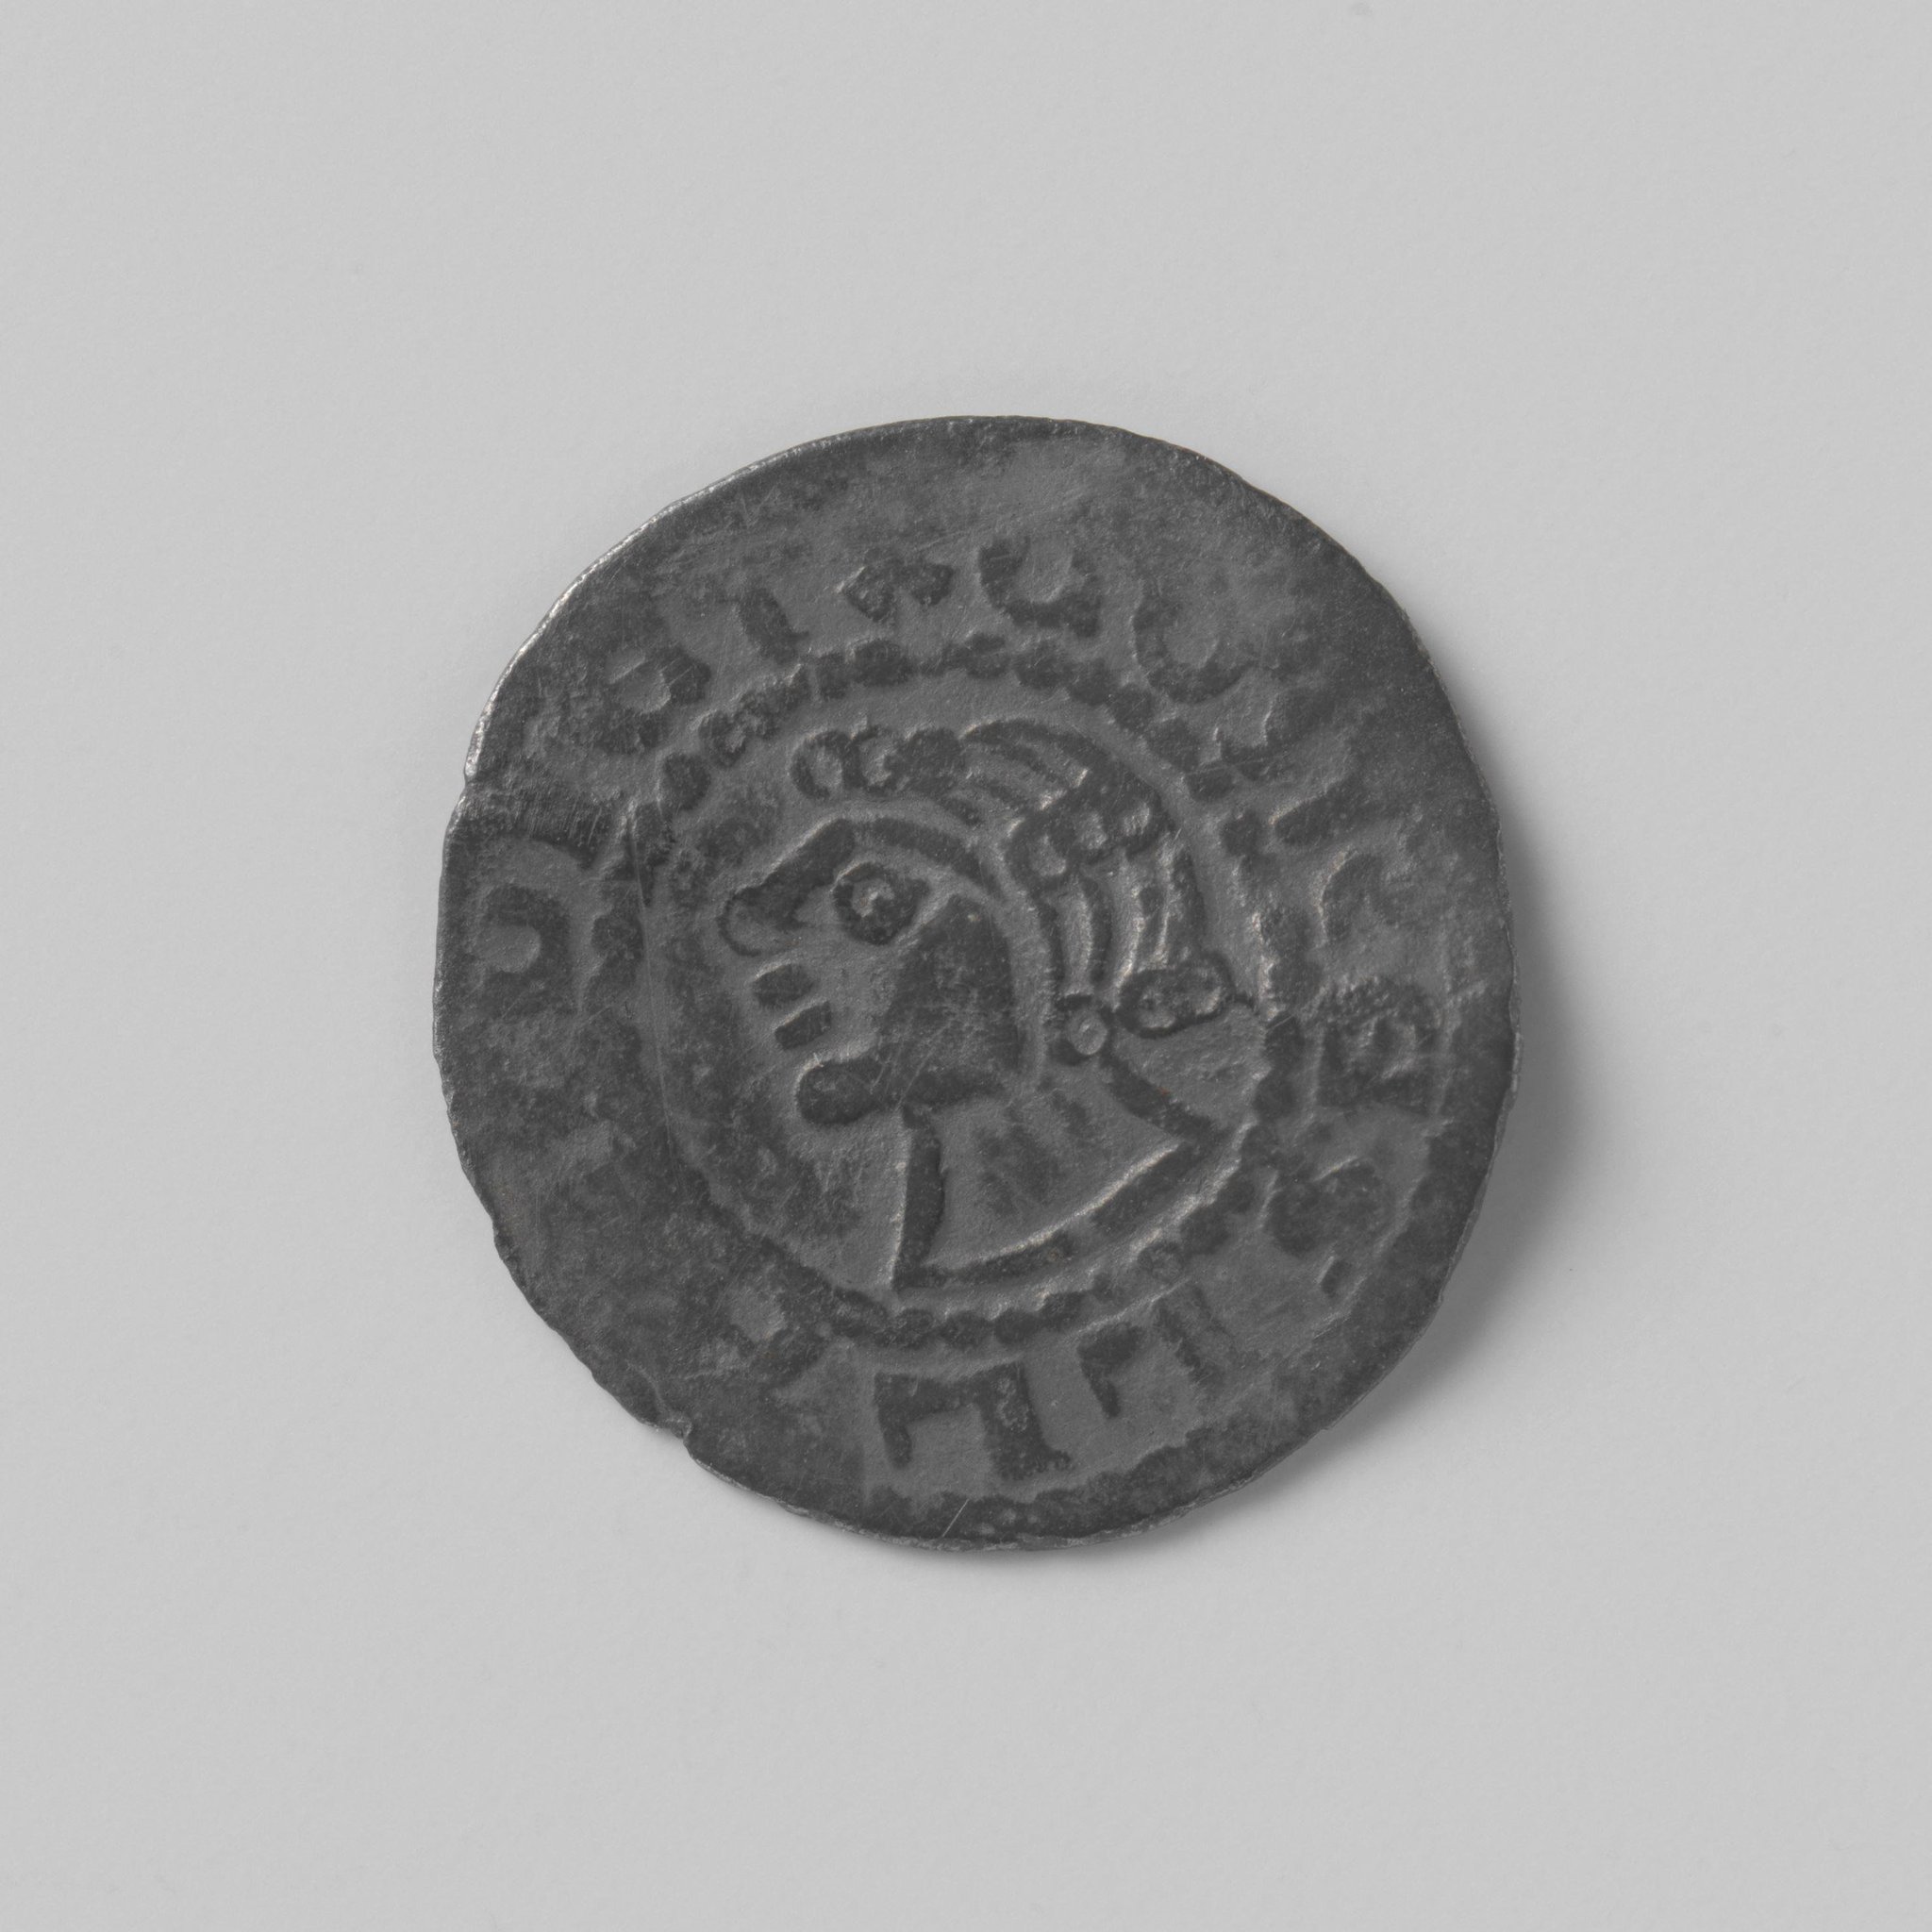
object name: penny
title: Hollandse penning van Floris V, 1256-1296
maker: floris v (graaf van holland en zeeland)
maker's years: 1254-1296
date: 1284-1286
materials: silver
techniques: striking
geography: dordrecht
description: Zilveren munt. Voorzijde: hoofd met gravenmuts naar links. Keerzijde: lang dubbellijnig kruis, in hoeken vijfpuntige spoorrradertjes.